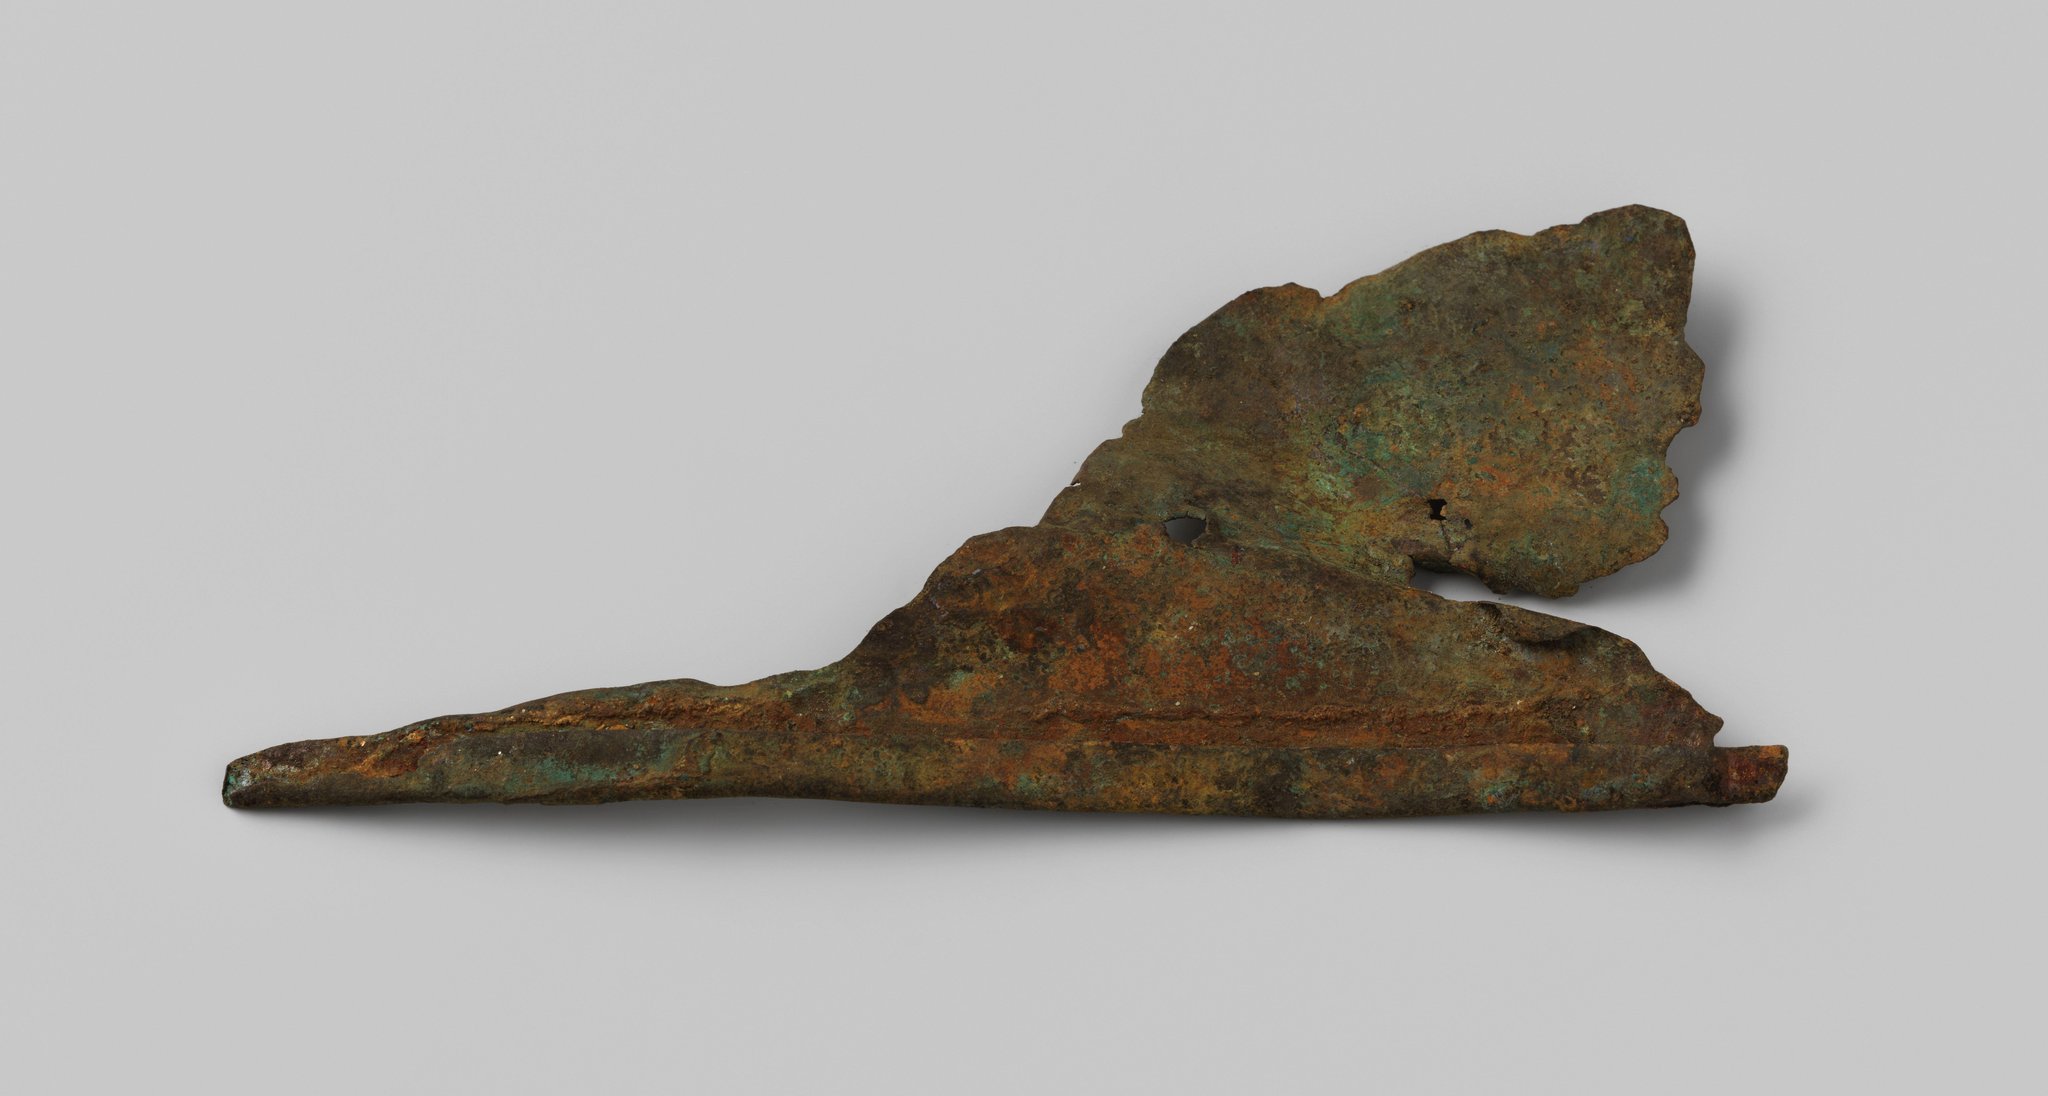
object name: fragment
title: Fragment koper uit het wrak van de Oost-Indiëvaarder Hollandia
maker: Anonymous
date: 1700-1743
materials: copper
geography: netherlands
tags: verenigde oostindische compagnie, hollandia (schip), annet